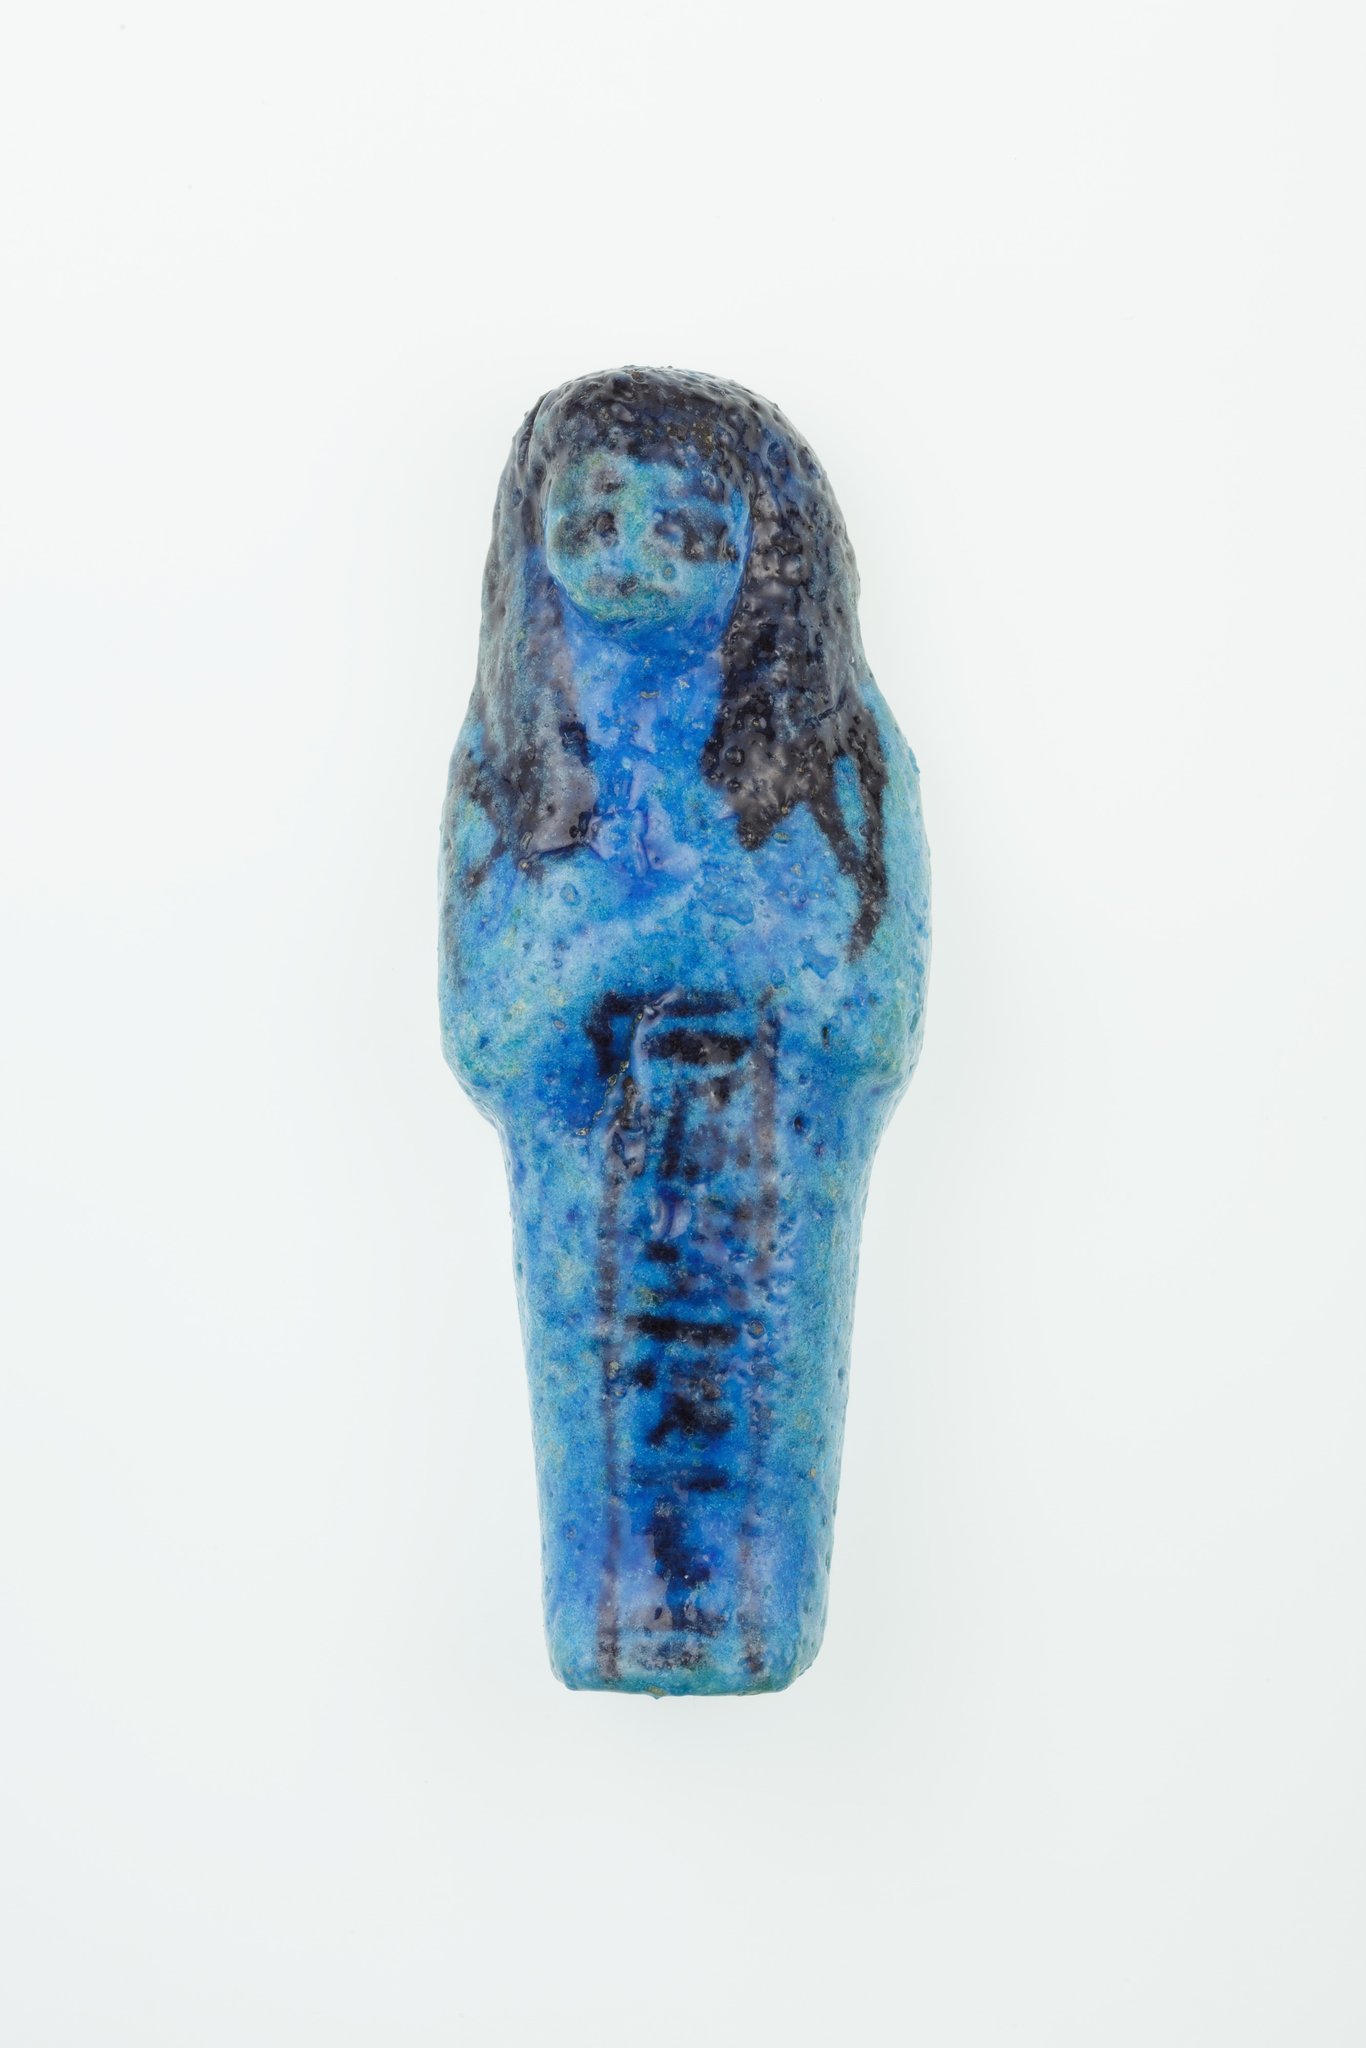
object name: shabti, worker, nauny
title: Worker Shabti of Nauny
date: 1050 BCE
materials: faience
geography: egypt